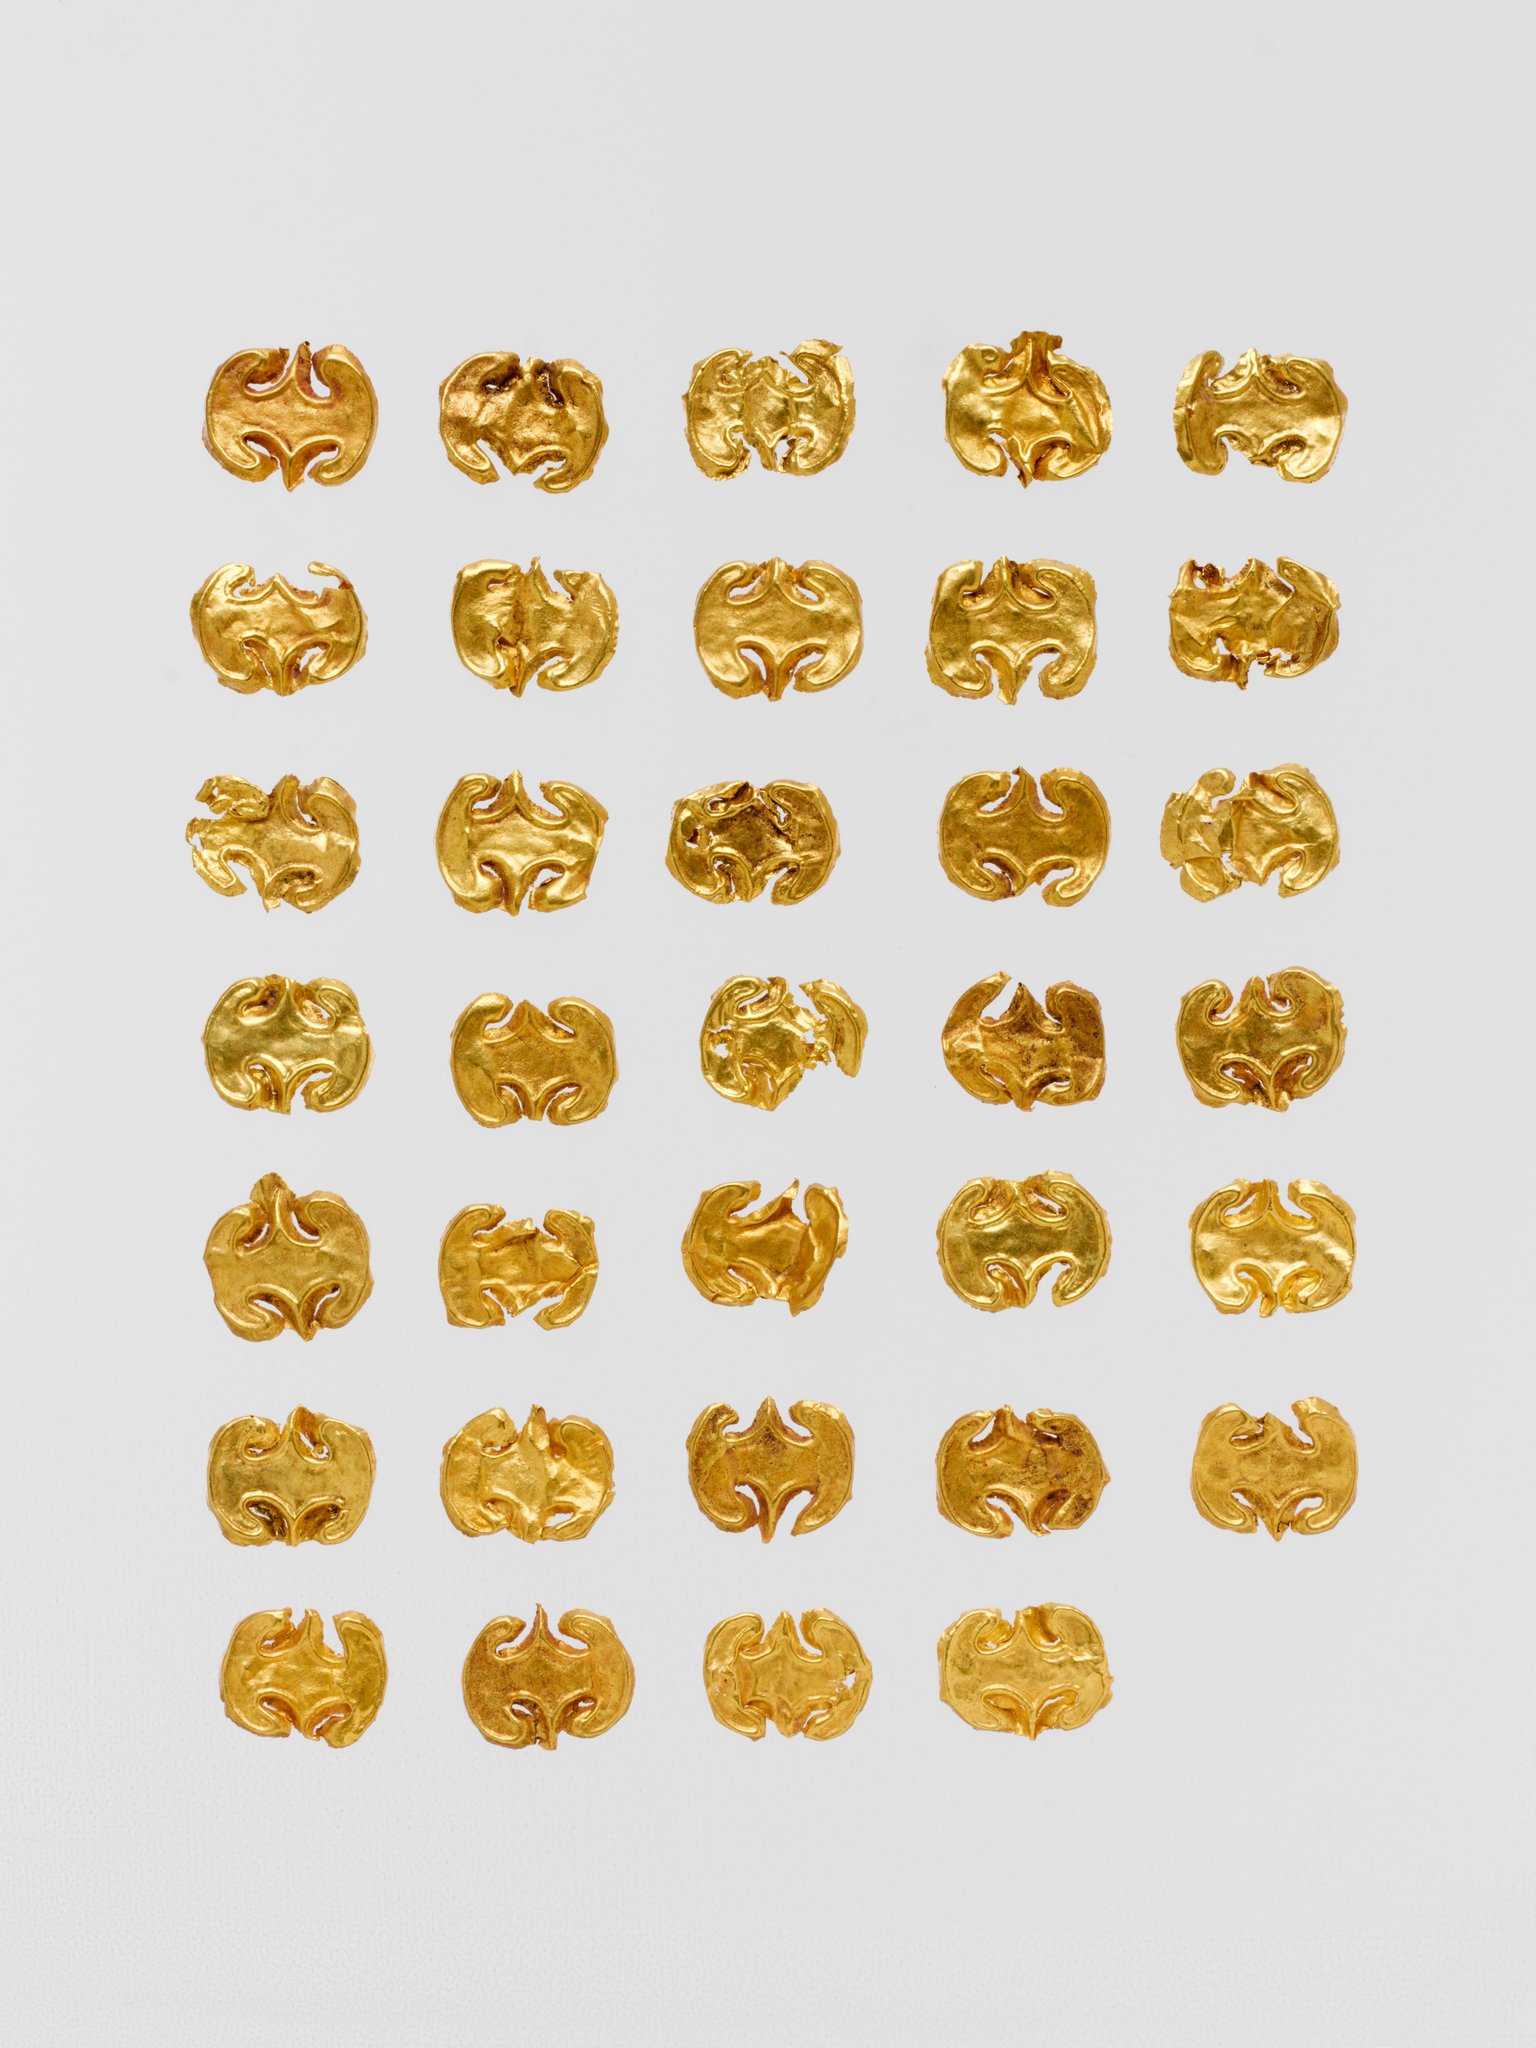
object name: dress ornament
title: Thirty-four gold dress ornaments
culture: roman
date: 100 BCE-100 CE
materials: gold